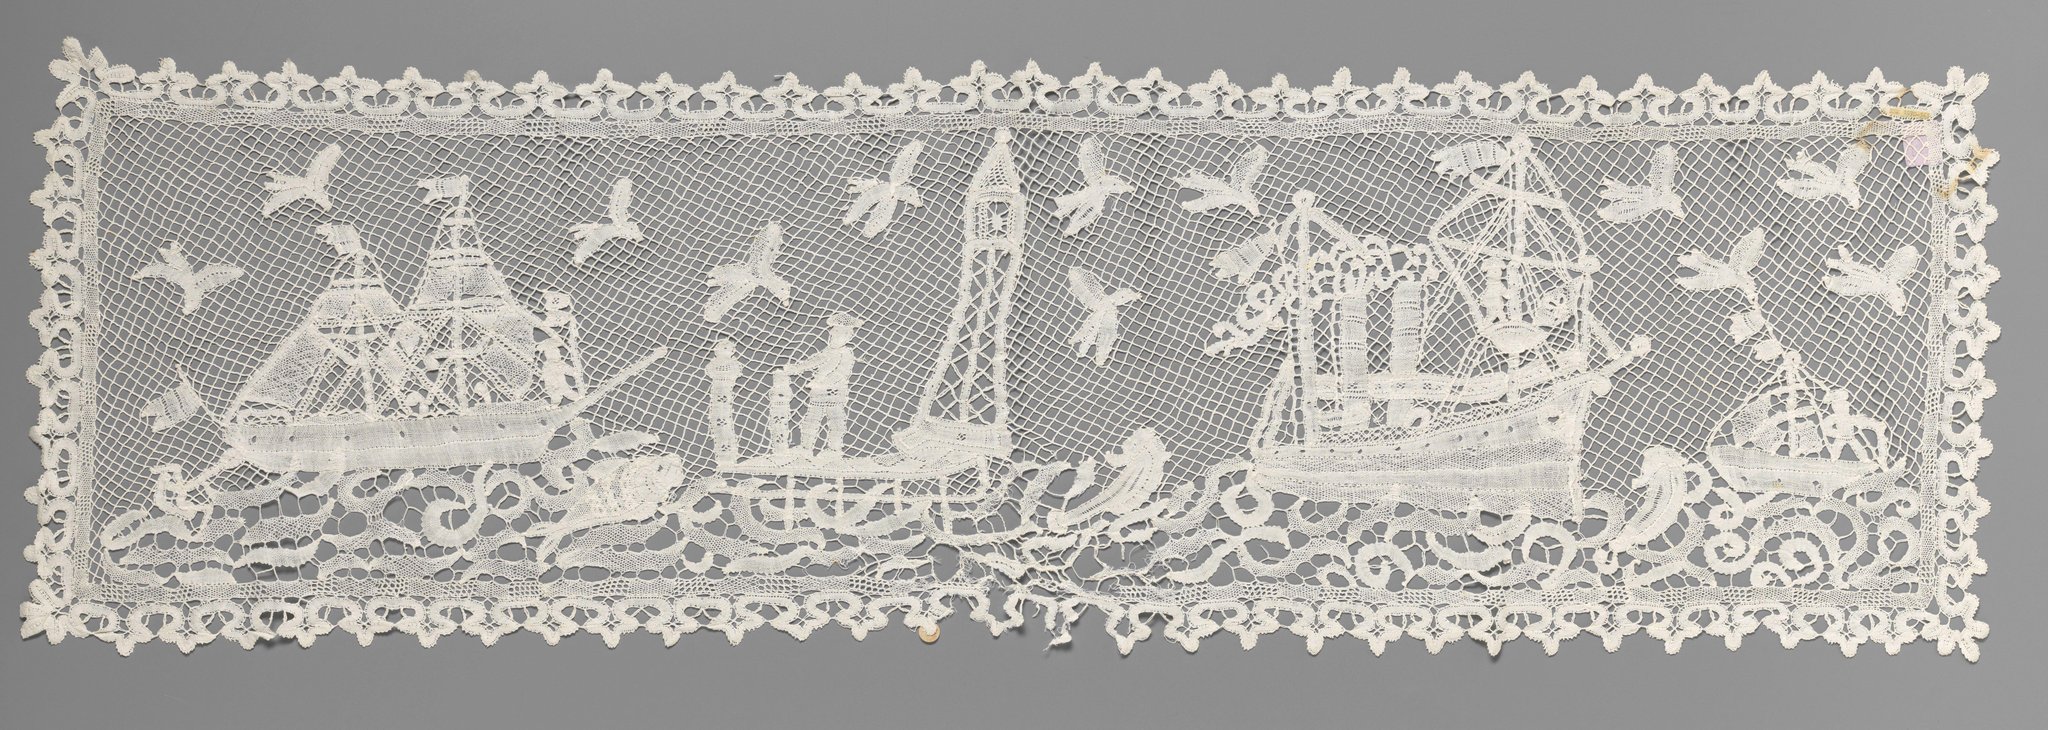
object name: kleed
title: Langwerpig kleed van kloskant met zeilschepen en een man naast een vuurtoren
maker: Anonymous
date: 1900-1949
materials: lace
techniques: lace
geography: bruges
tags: lighthouse, lightship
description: Langwerpig kleed van naturelkleurige kloskant, zeer grove kant in de techniek van duchesse-kant. Patroon van twee zeilschepen en een stoomboot op zee. In het midden staat een man op een vlonder naast een vuurtoren. In de zee zwemmen vissen en in de lucht vliegen vogels. Zeer grove vierkante vlechtengrond.